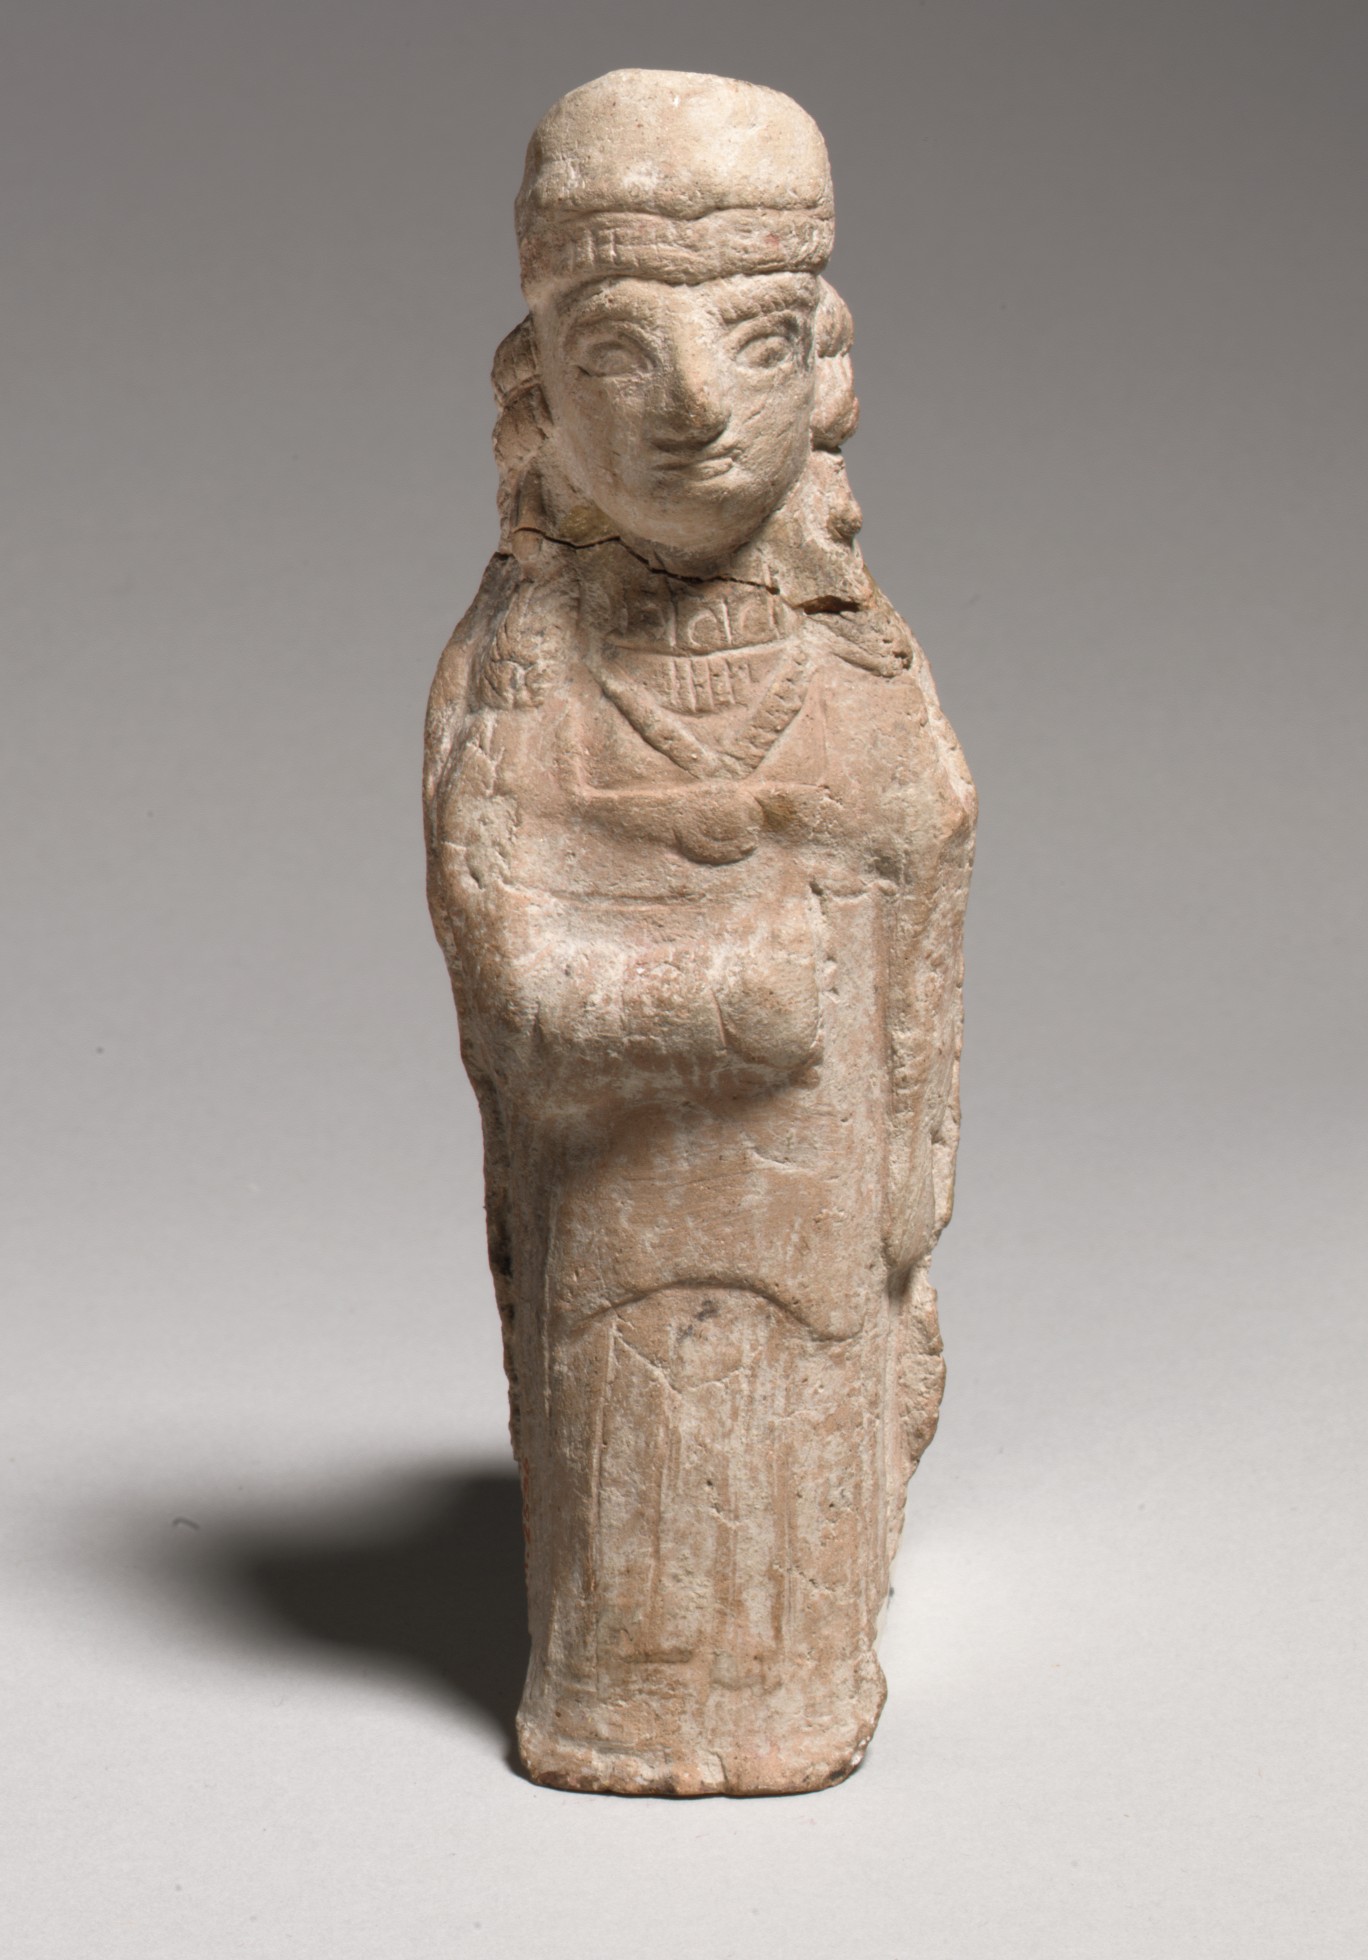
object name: statuette of a woman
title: Standing female figurine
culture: cypriot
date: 600-480 BCE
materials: terracotta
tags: women